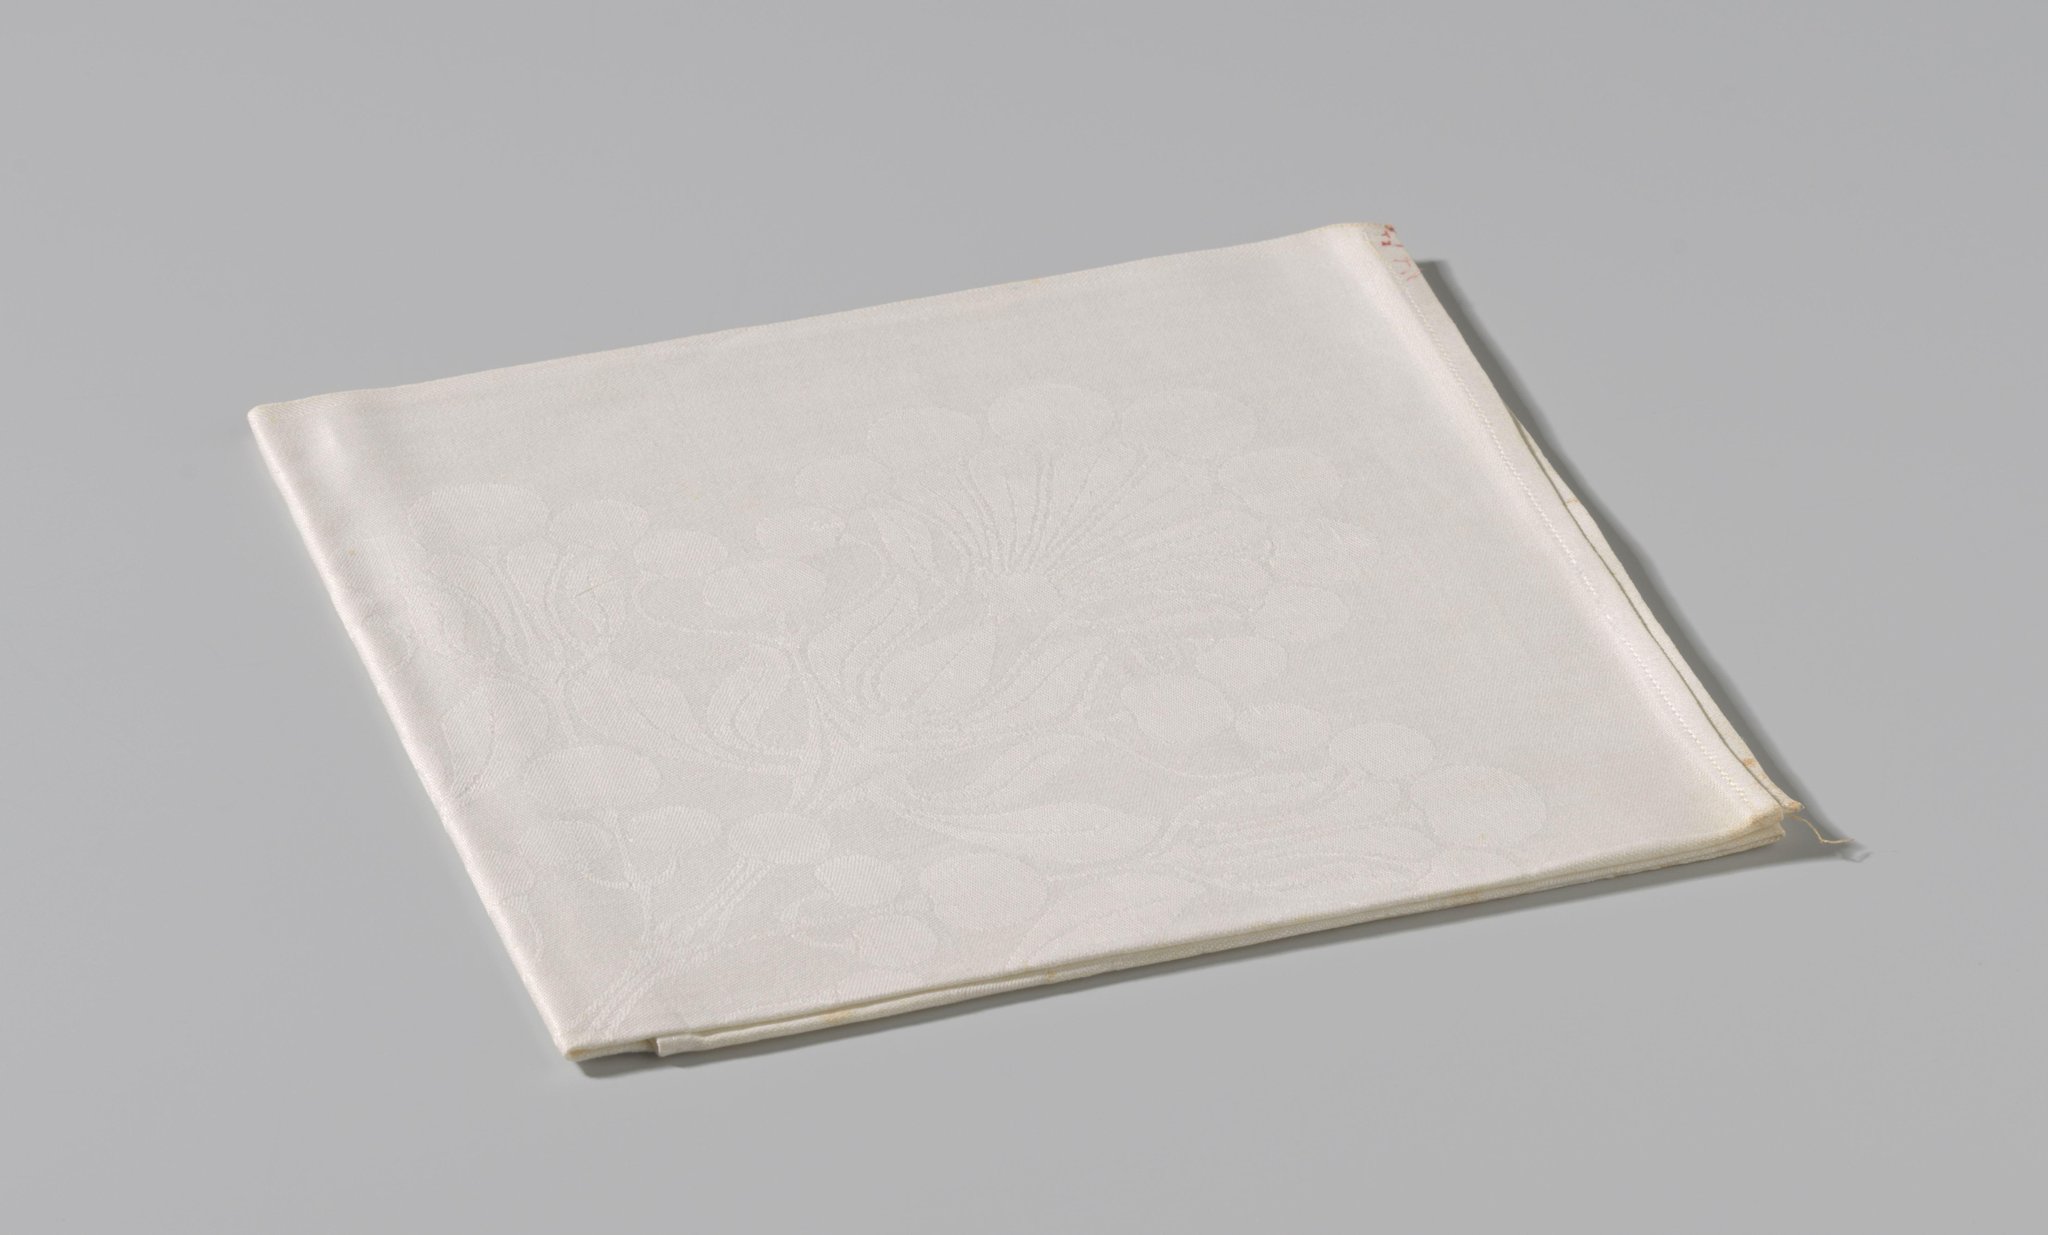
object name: napkin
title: Servet van linnendamast met kersen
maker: chris lebeau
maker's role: draughtsman, print maker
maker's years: 1878-1945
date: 1900-1925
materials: linen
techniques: damask, weave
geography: eindhoven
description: Servet van linnendamast met kersen (dessin 600 van Chris Lebeau). Het servet hoort bij vijf servetten (BK-1971-62-A t/m BK-1971-62-F) en een tafellaken (BK-1971-61).